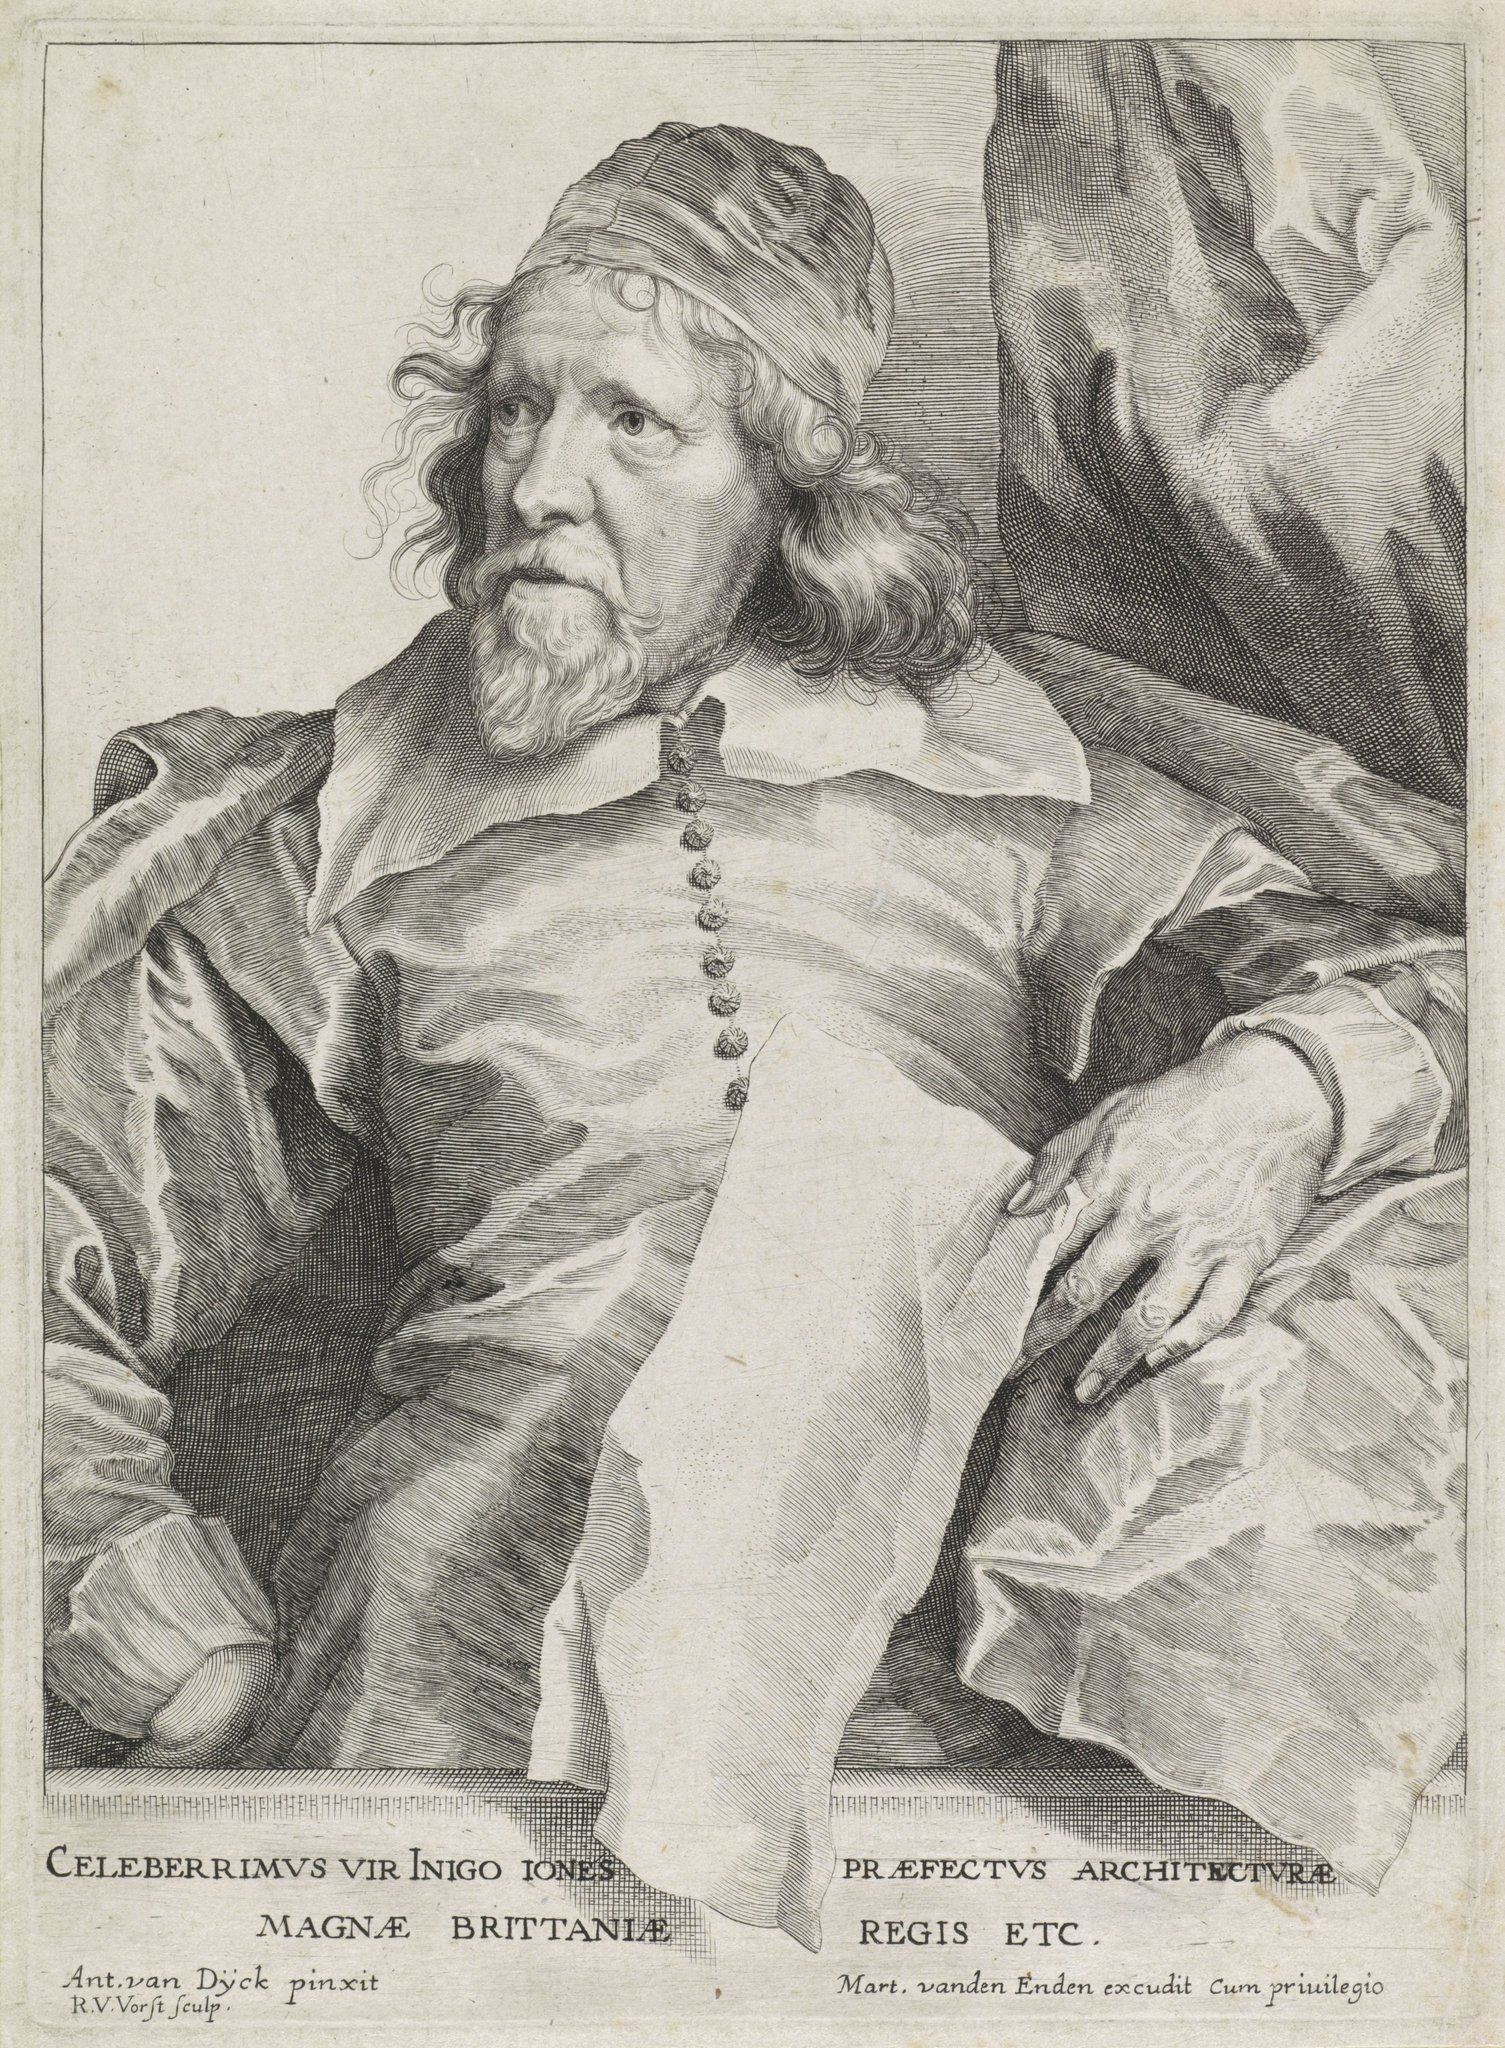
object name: print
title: Portret van Inigo Jones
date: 1627-1636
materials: paper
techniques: engraving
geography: london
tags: london, physicist, paper (writing material)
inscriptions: collector's mark: Lugt 240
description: Portet van de Engelse architect Inigo Jones. In zijn hand een vel papier.